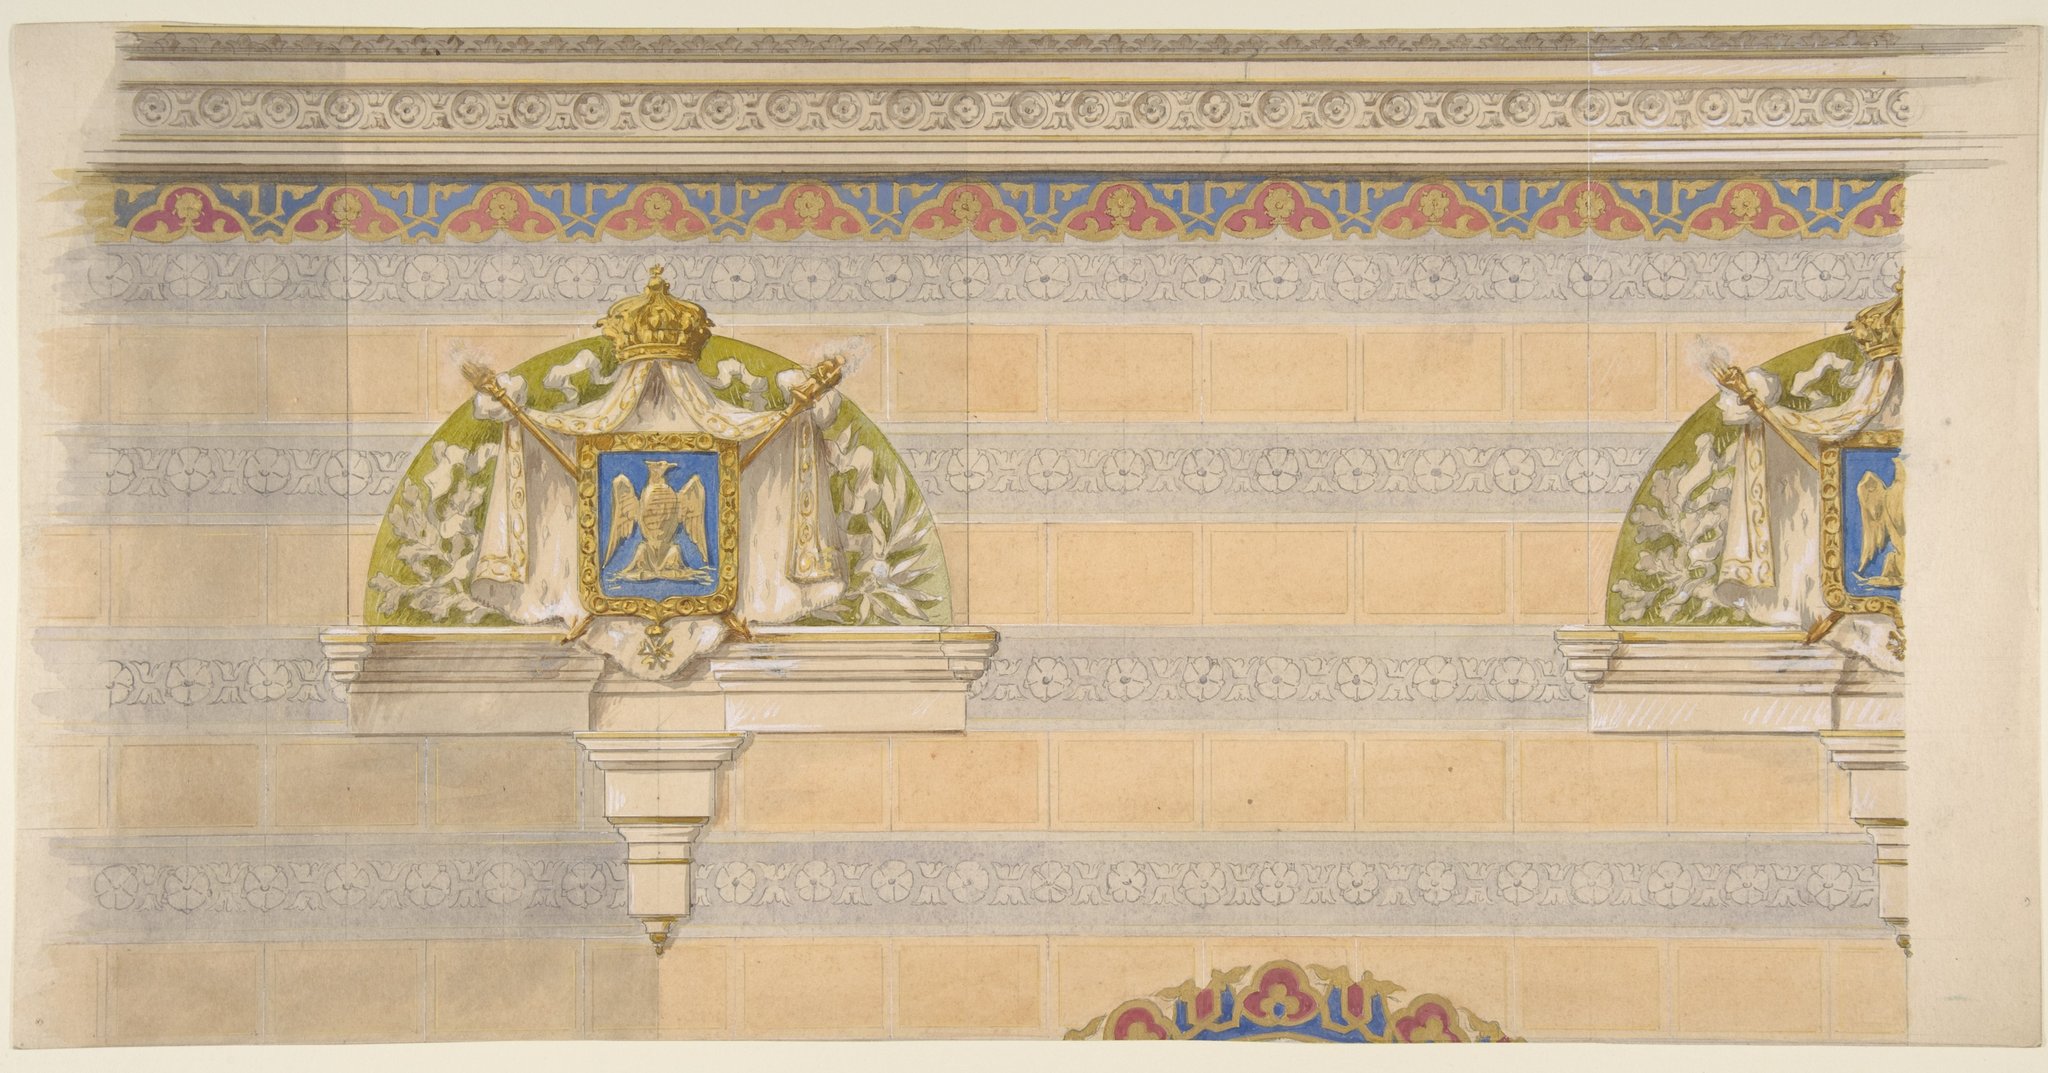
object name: drawing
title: Design for Upper Wall Decoration, Farnborough, England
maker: jules-edmond-charles lachaise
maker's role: artist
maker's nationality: french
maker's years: 1897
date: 1880-1886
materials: gilt, watercolor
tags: coat of arms